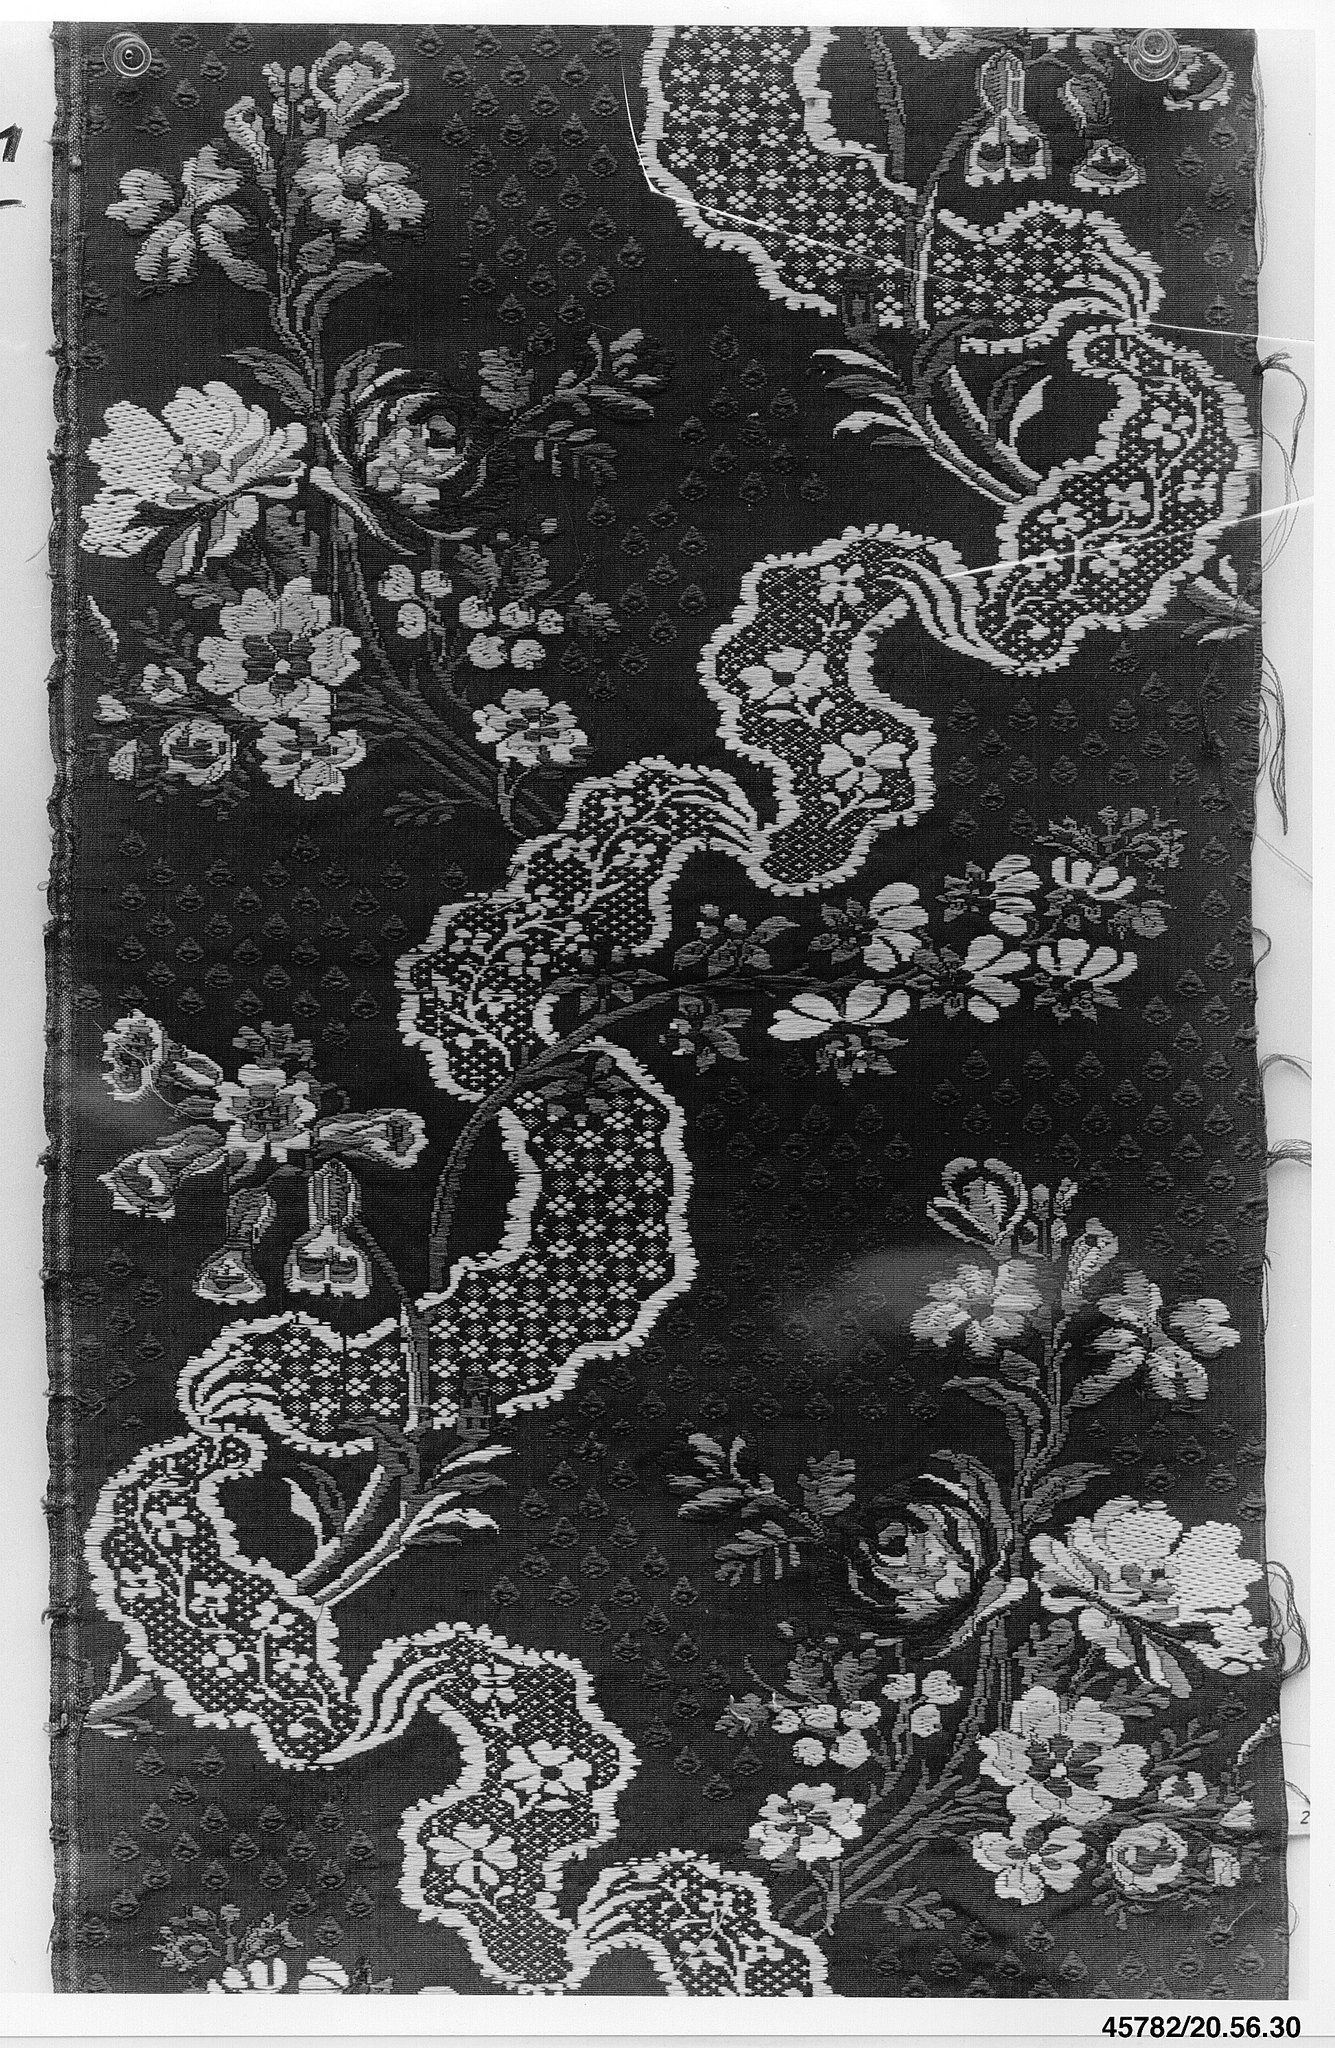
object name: piece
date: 1760-1770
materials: silk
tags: flowers,leaves